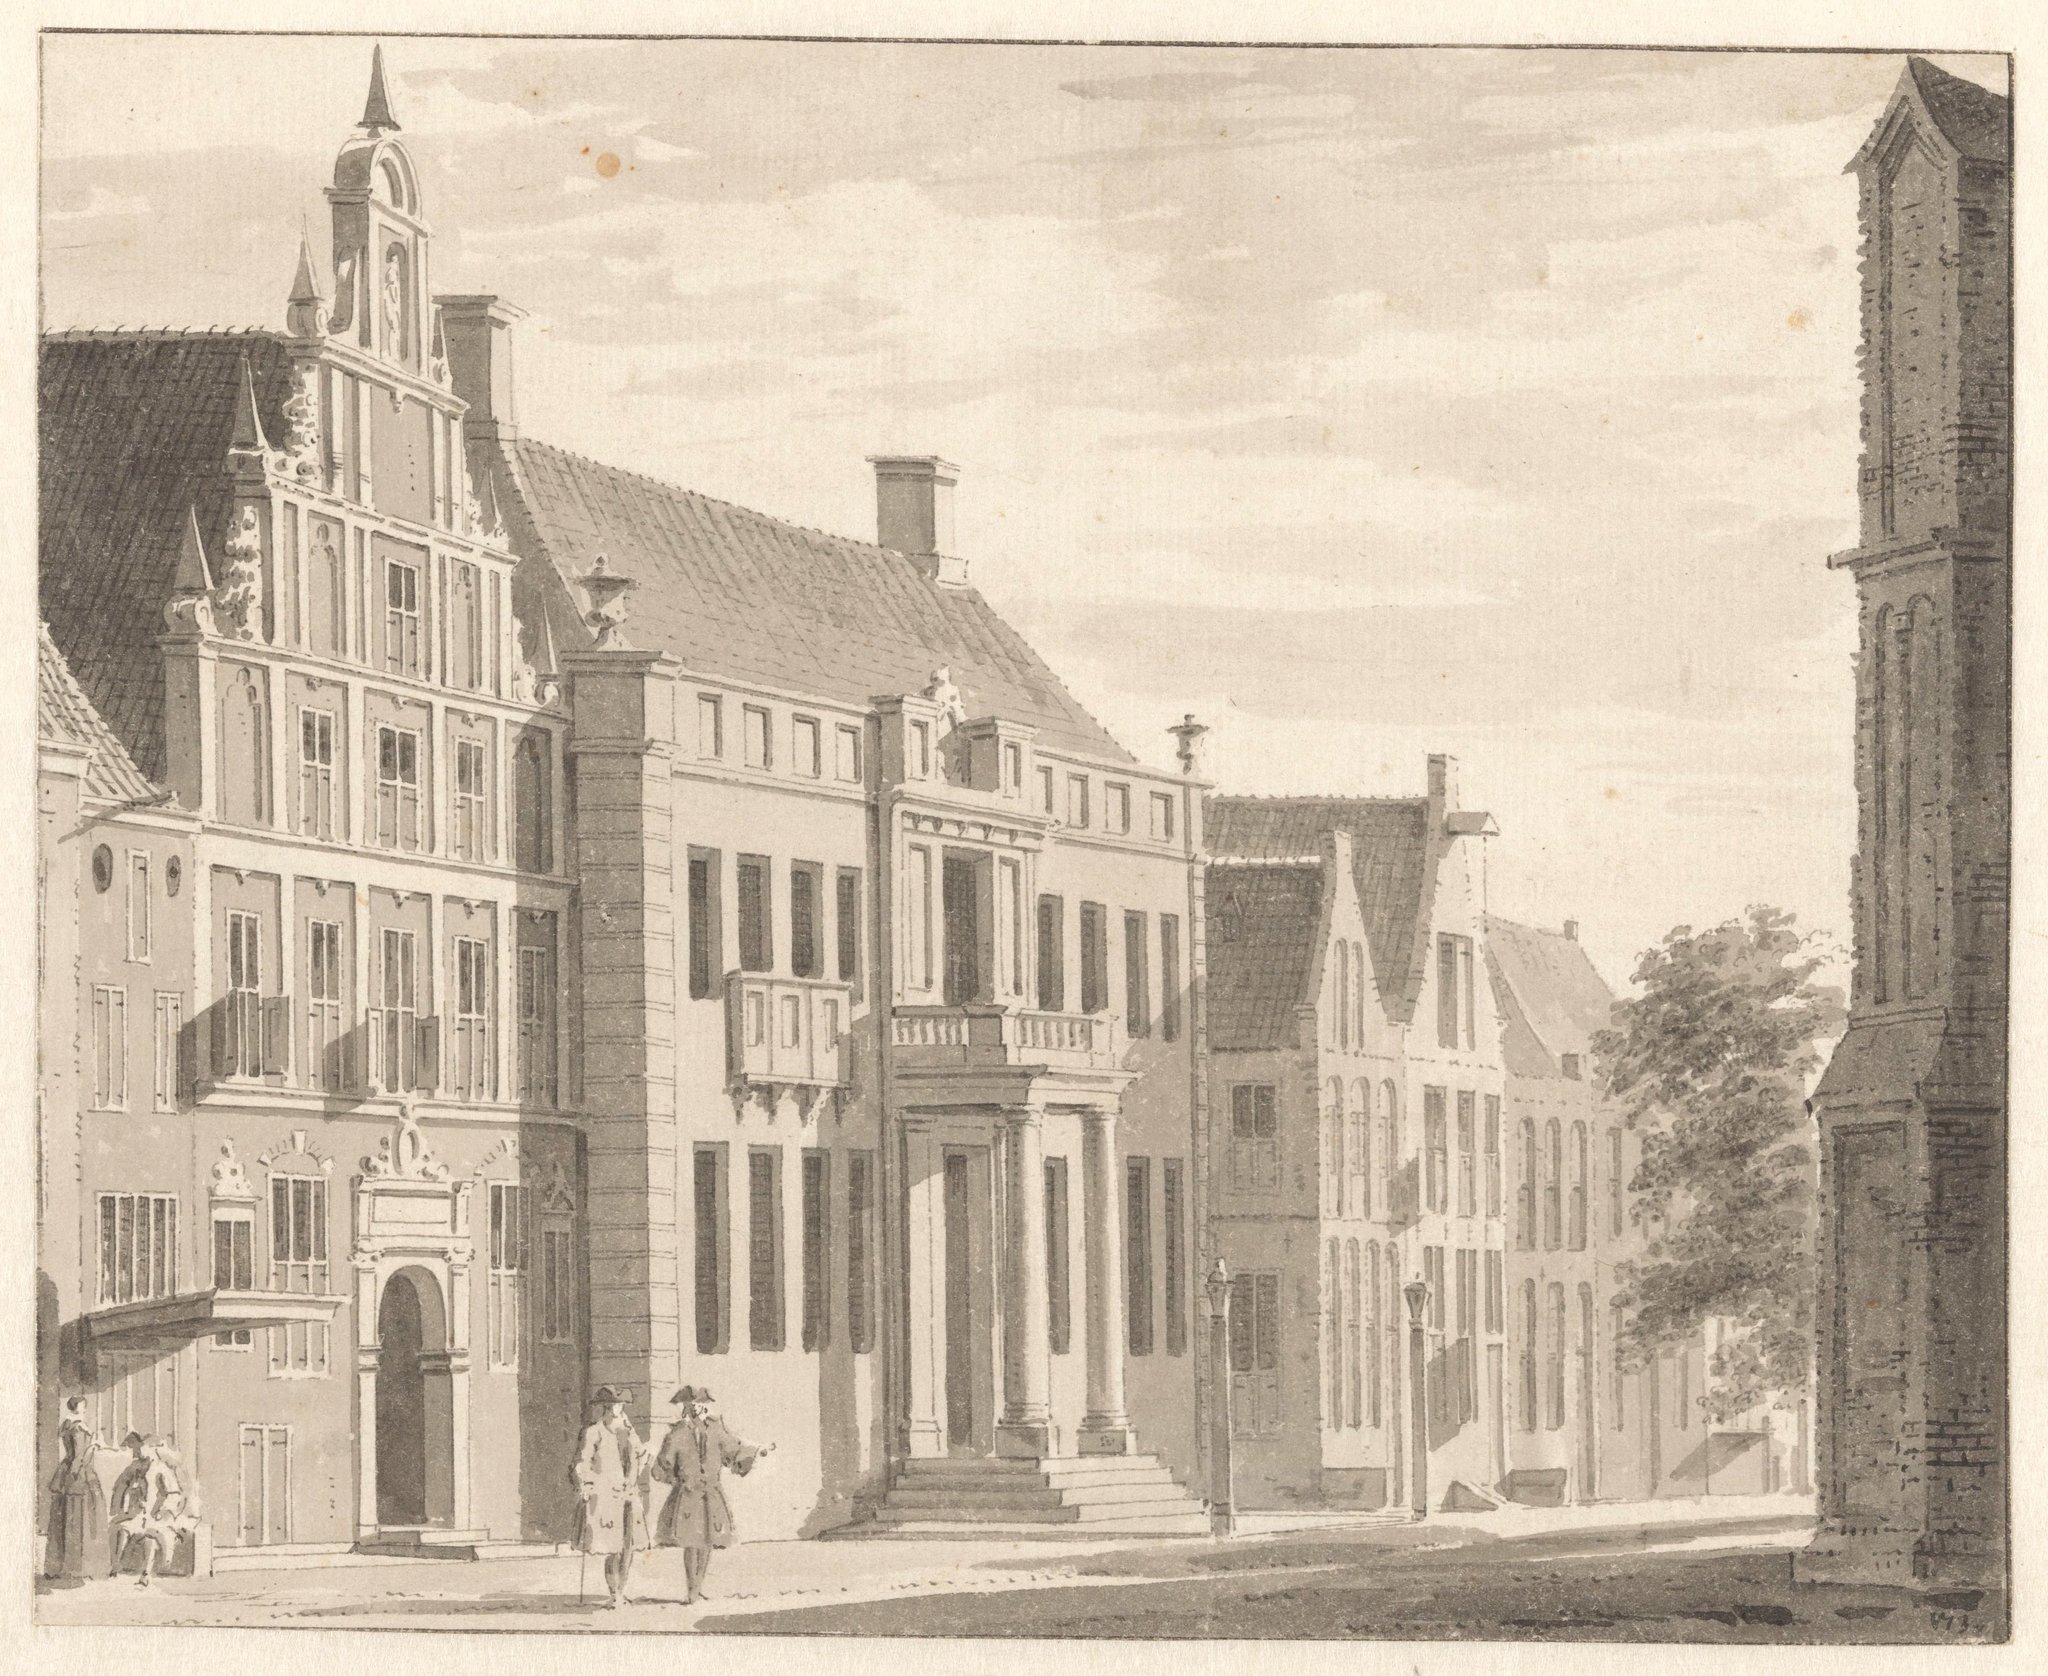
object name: drawing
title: Gezicht op het Grote Kerkhof te Deventer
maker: cornelis pronk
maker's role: draughtsman, painter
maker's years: 1691-1759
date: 1730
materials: ink, paper, pencil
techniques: brush, pen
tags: street, deventer